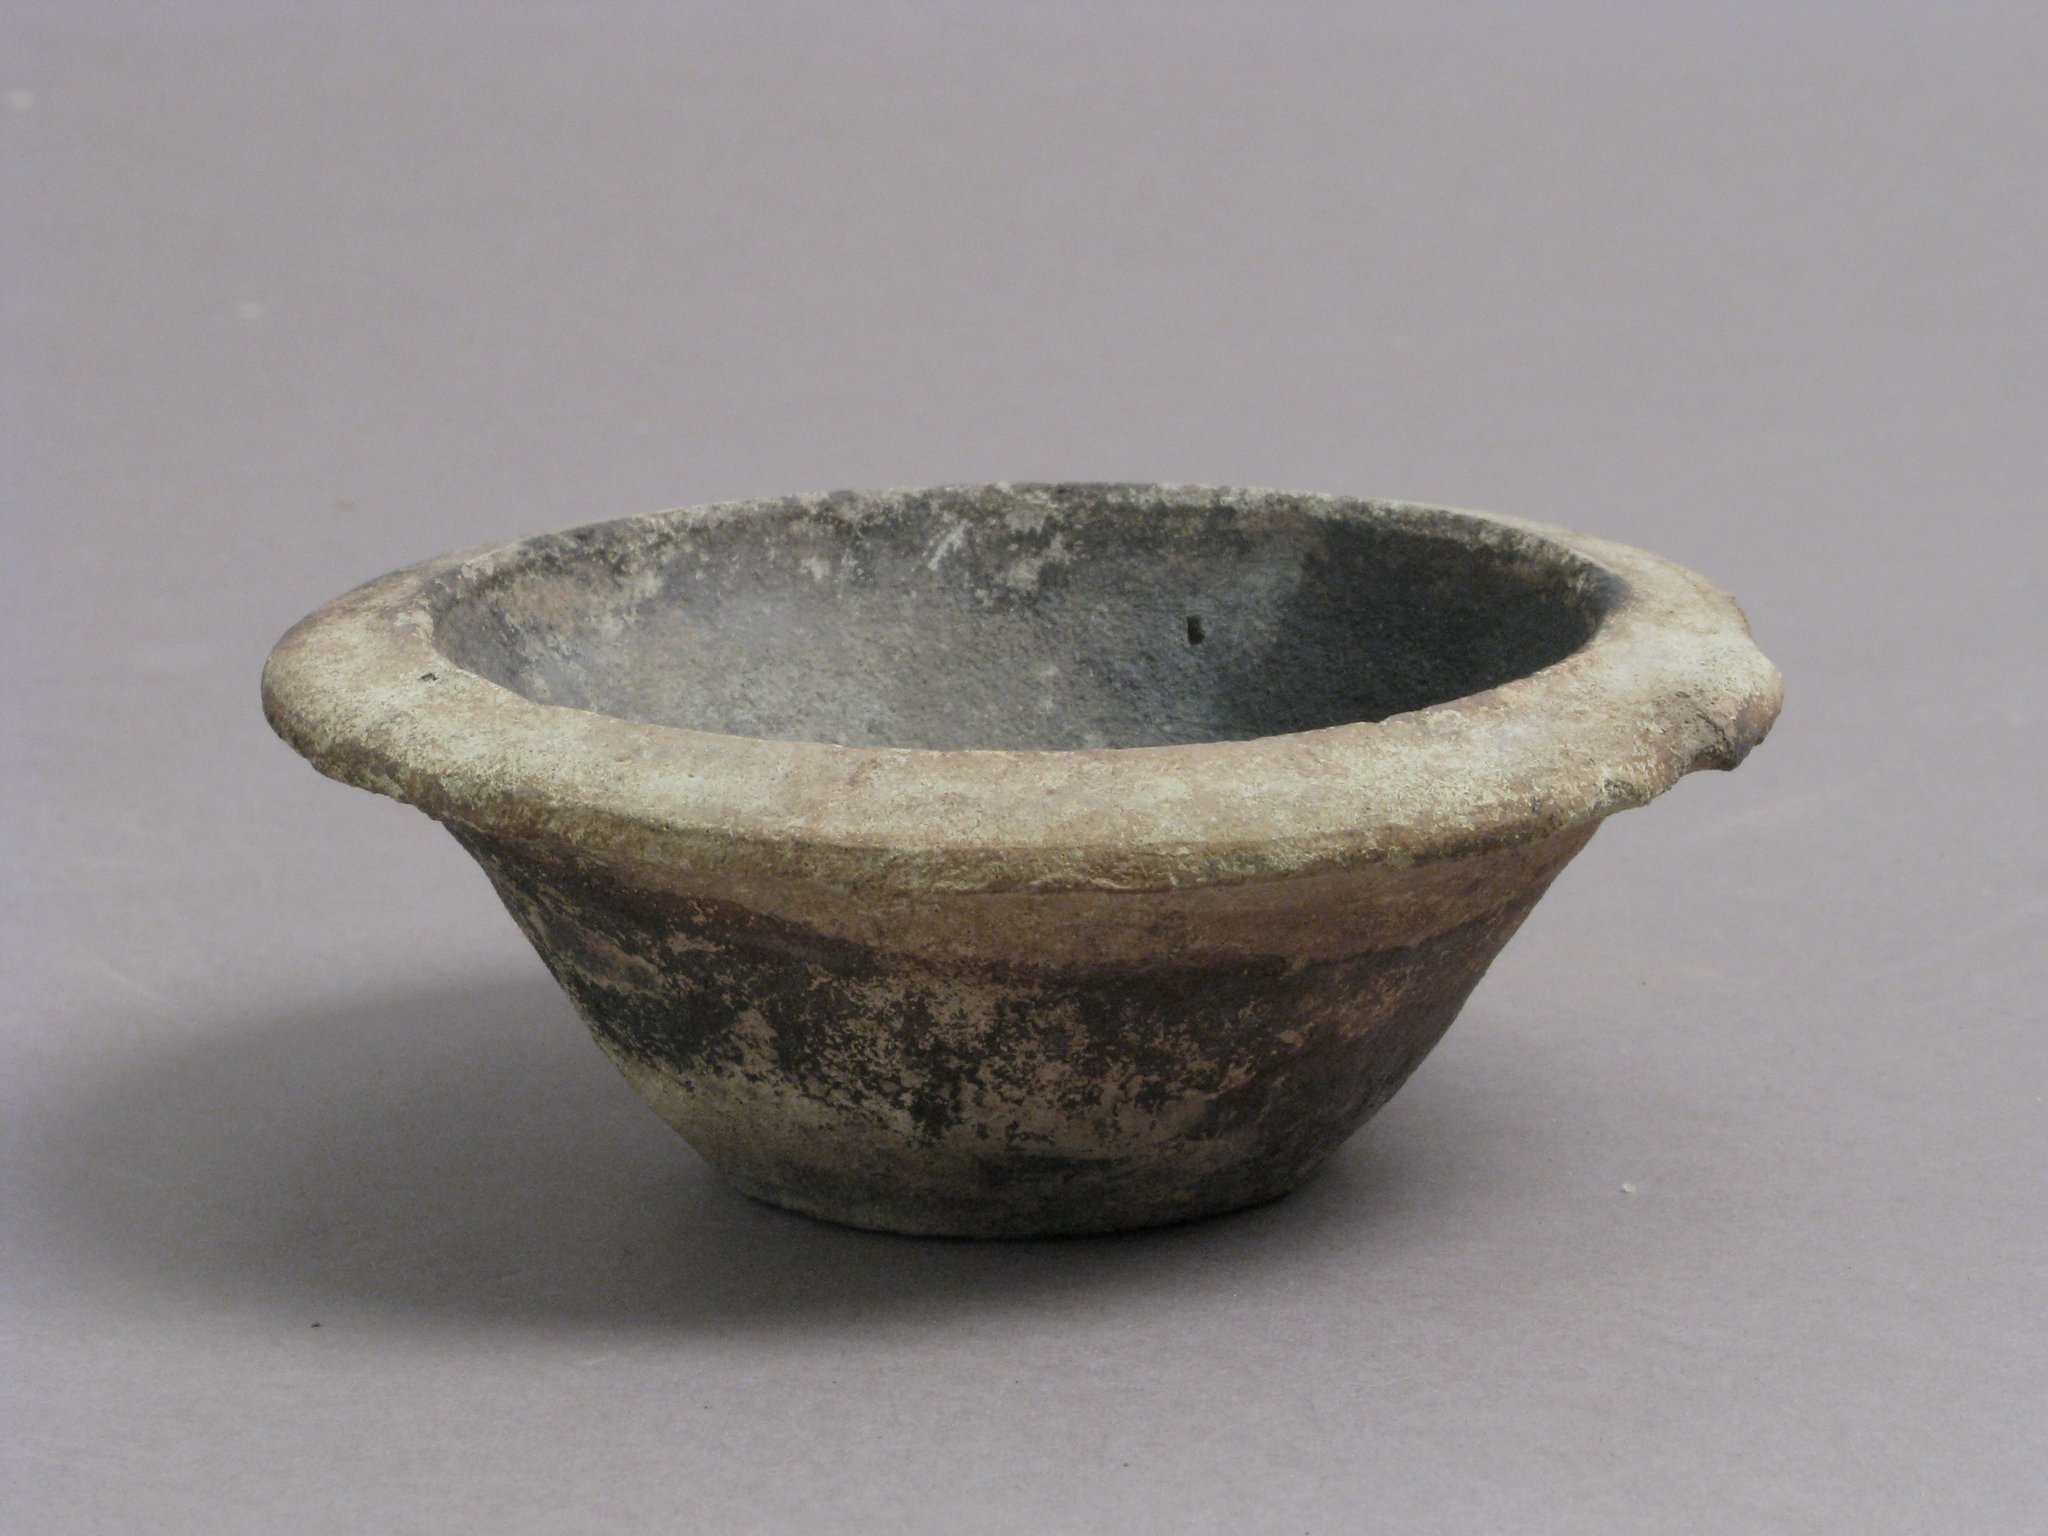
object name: bowl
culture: coptic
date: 301-700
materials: earthenware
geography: egypt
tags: bowls